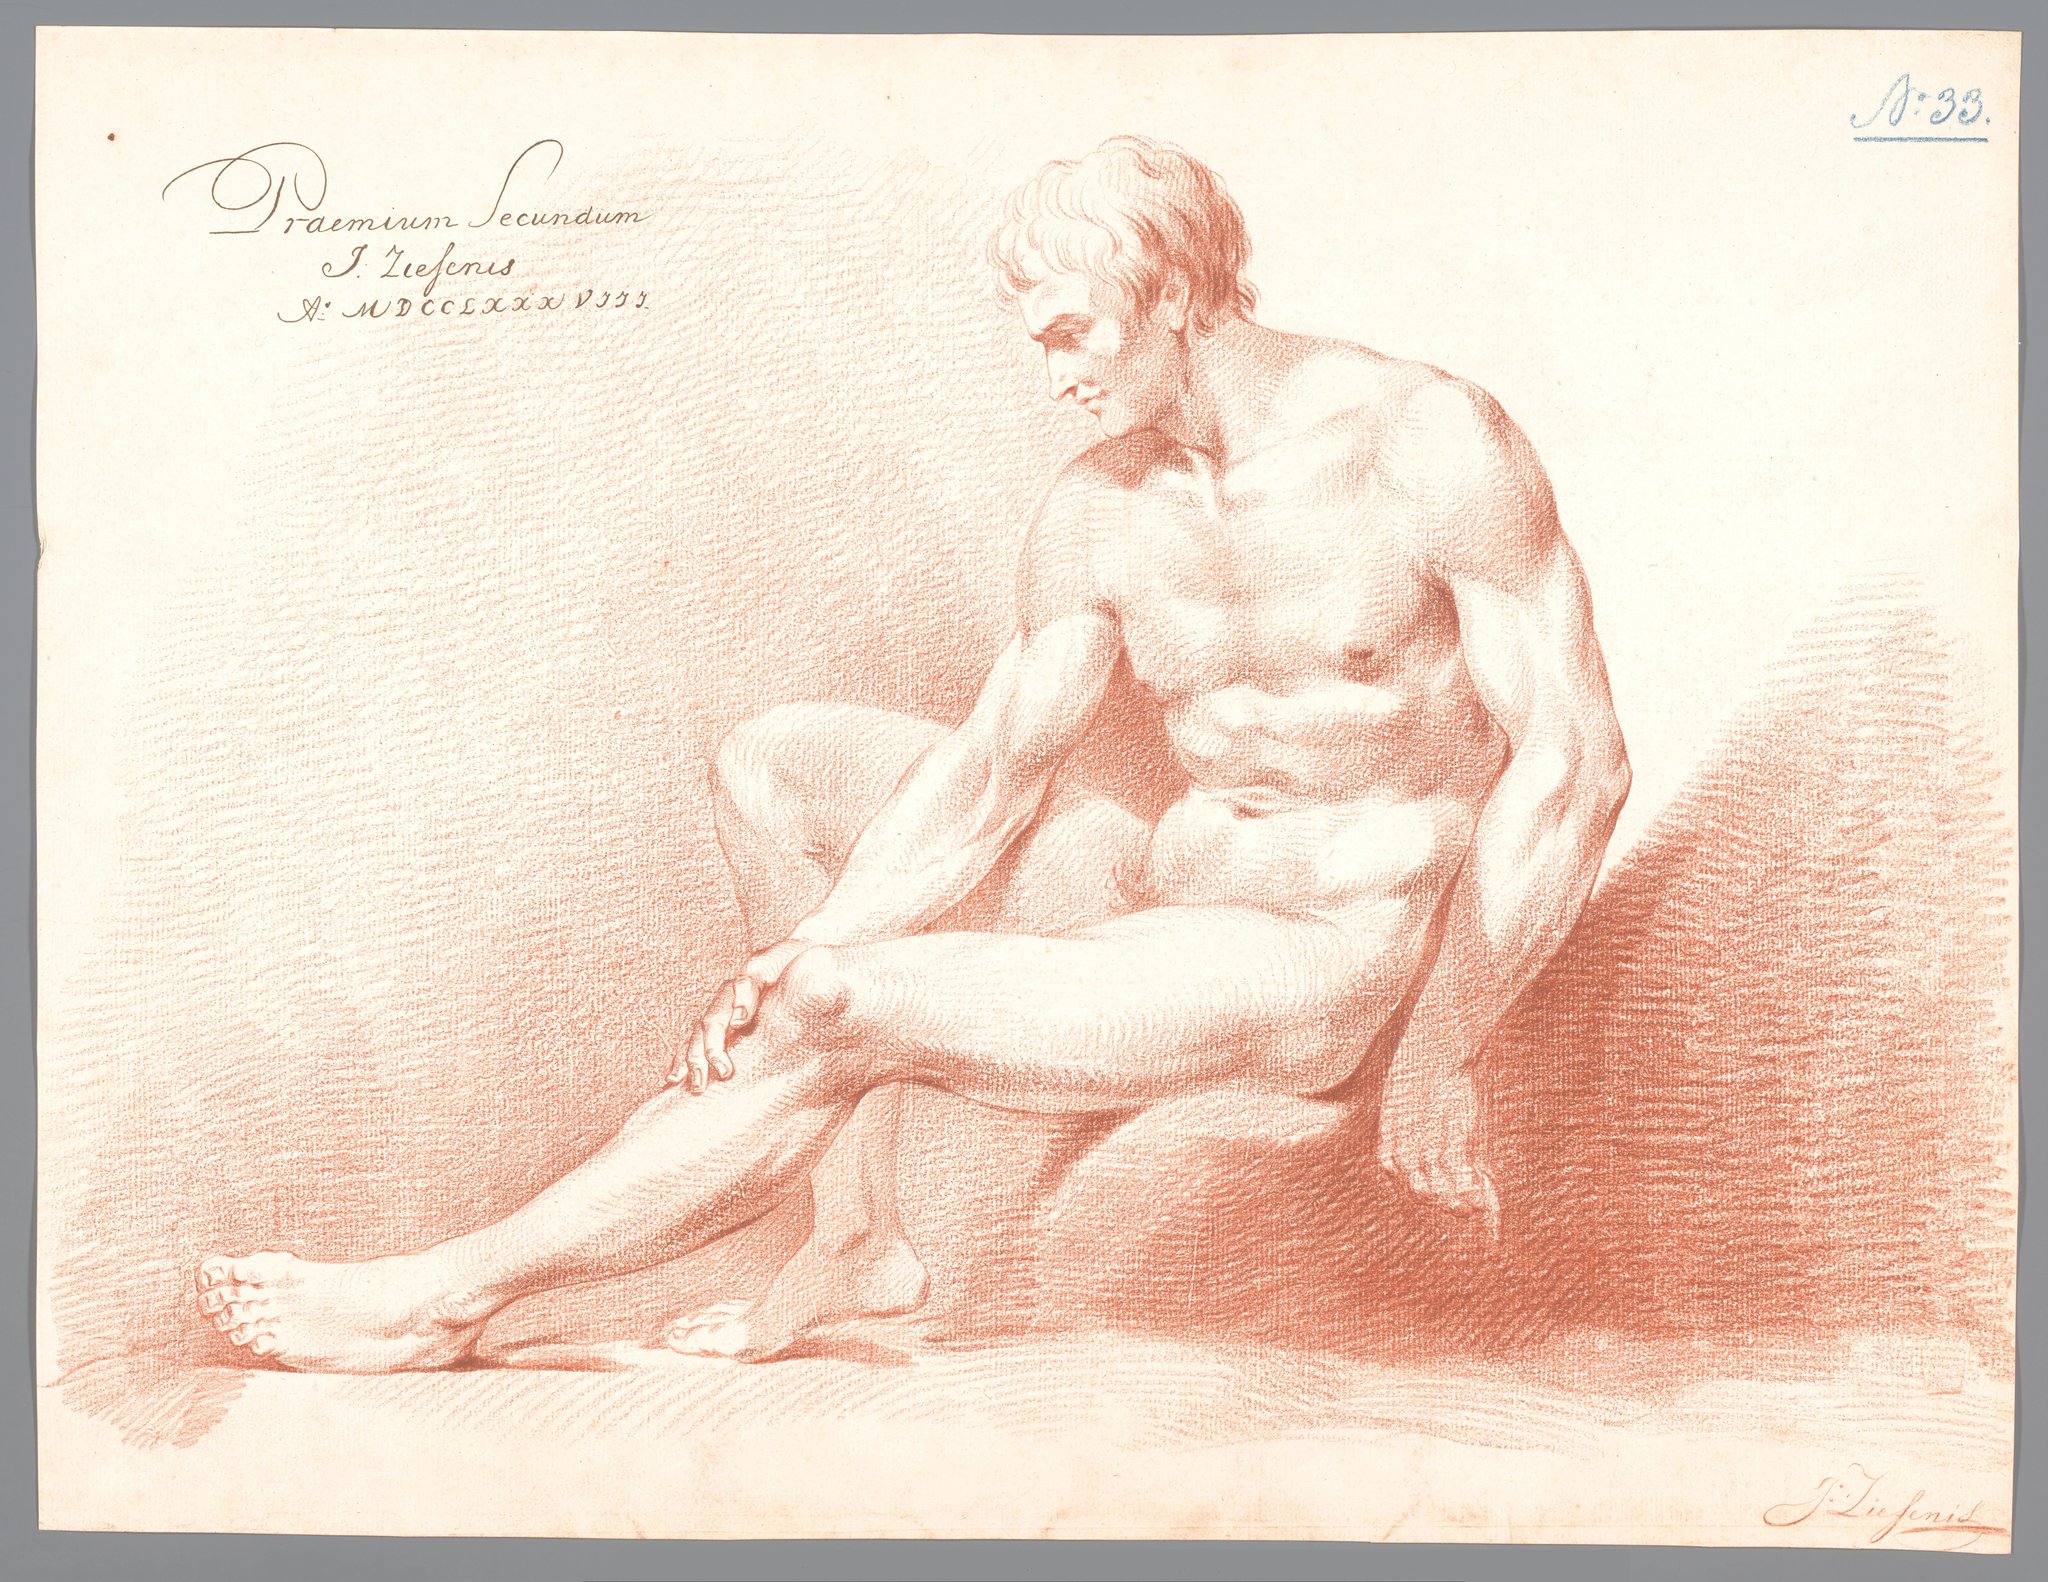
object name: drawing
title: Zittend mannelijk naakt, van opzij gezien (2e prijs 1788)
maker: johannes ziesenis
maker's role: draughtsman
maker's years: 1770-1799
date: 1788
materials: chalk, paper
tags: sitting figure (+ nude human being)